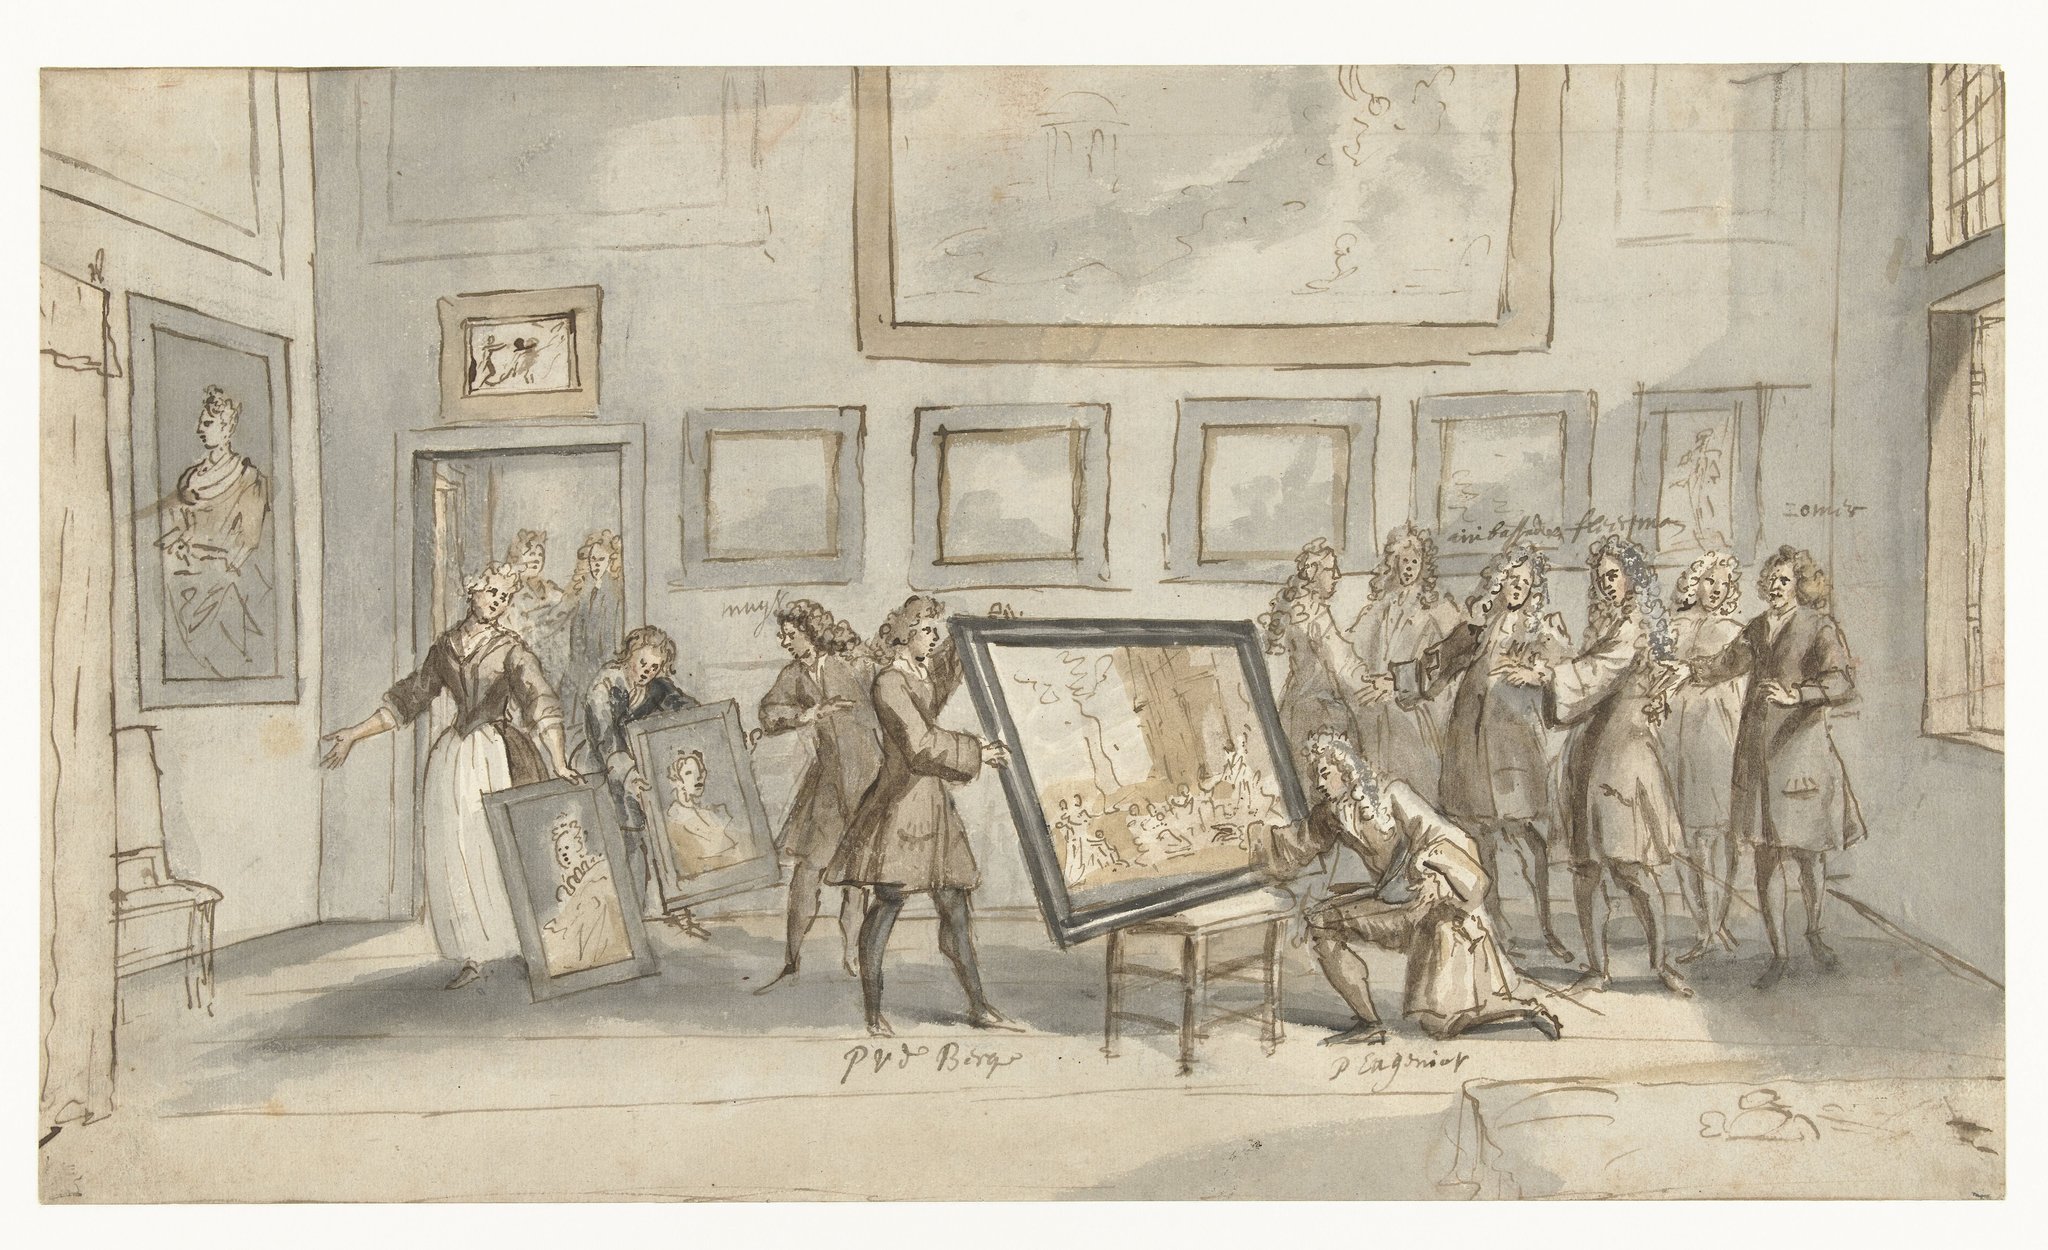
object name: drawing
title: Prins Eugenius van Savoye bij de kunsthandelaar J.P. Zomer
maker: pieter van den berge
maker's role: draughtsman, print maker, printer, publisher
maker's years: 1659-1737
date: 1701-1723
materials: ink, paper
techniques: brush, pen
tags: jan pietersz. zomer, amsterdam, print maker, draughtsman, printer, publisher, pieter van den berge, paris, vienna, eugenius van savoye, art collector, art dealer, picture, painting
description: Het bezoek van Prins Eugenius van Savoie, begeleid door de Gedeputeerde te velde Vleertman en andere heren aan de kunstkoper Jan Pietersz. Zomer te Amsterdam (April 1701?). De prins bekijkt knielend een schilderij dat voor hem op een stoel staat en door Pieter van den Berghe vastgehouden wordt.